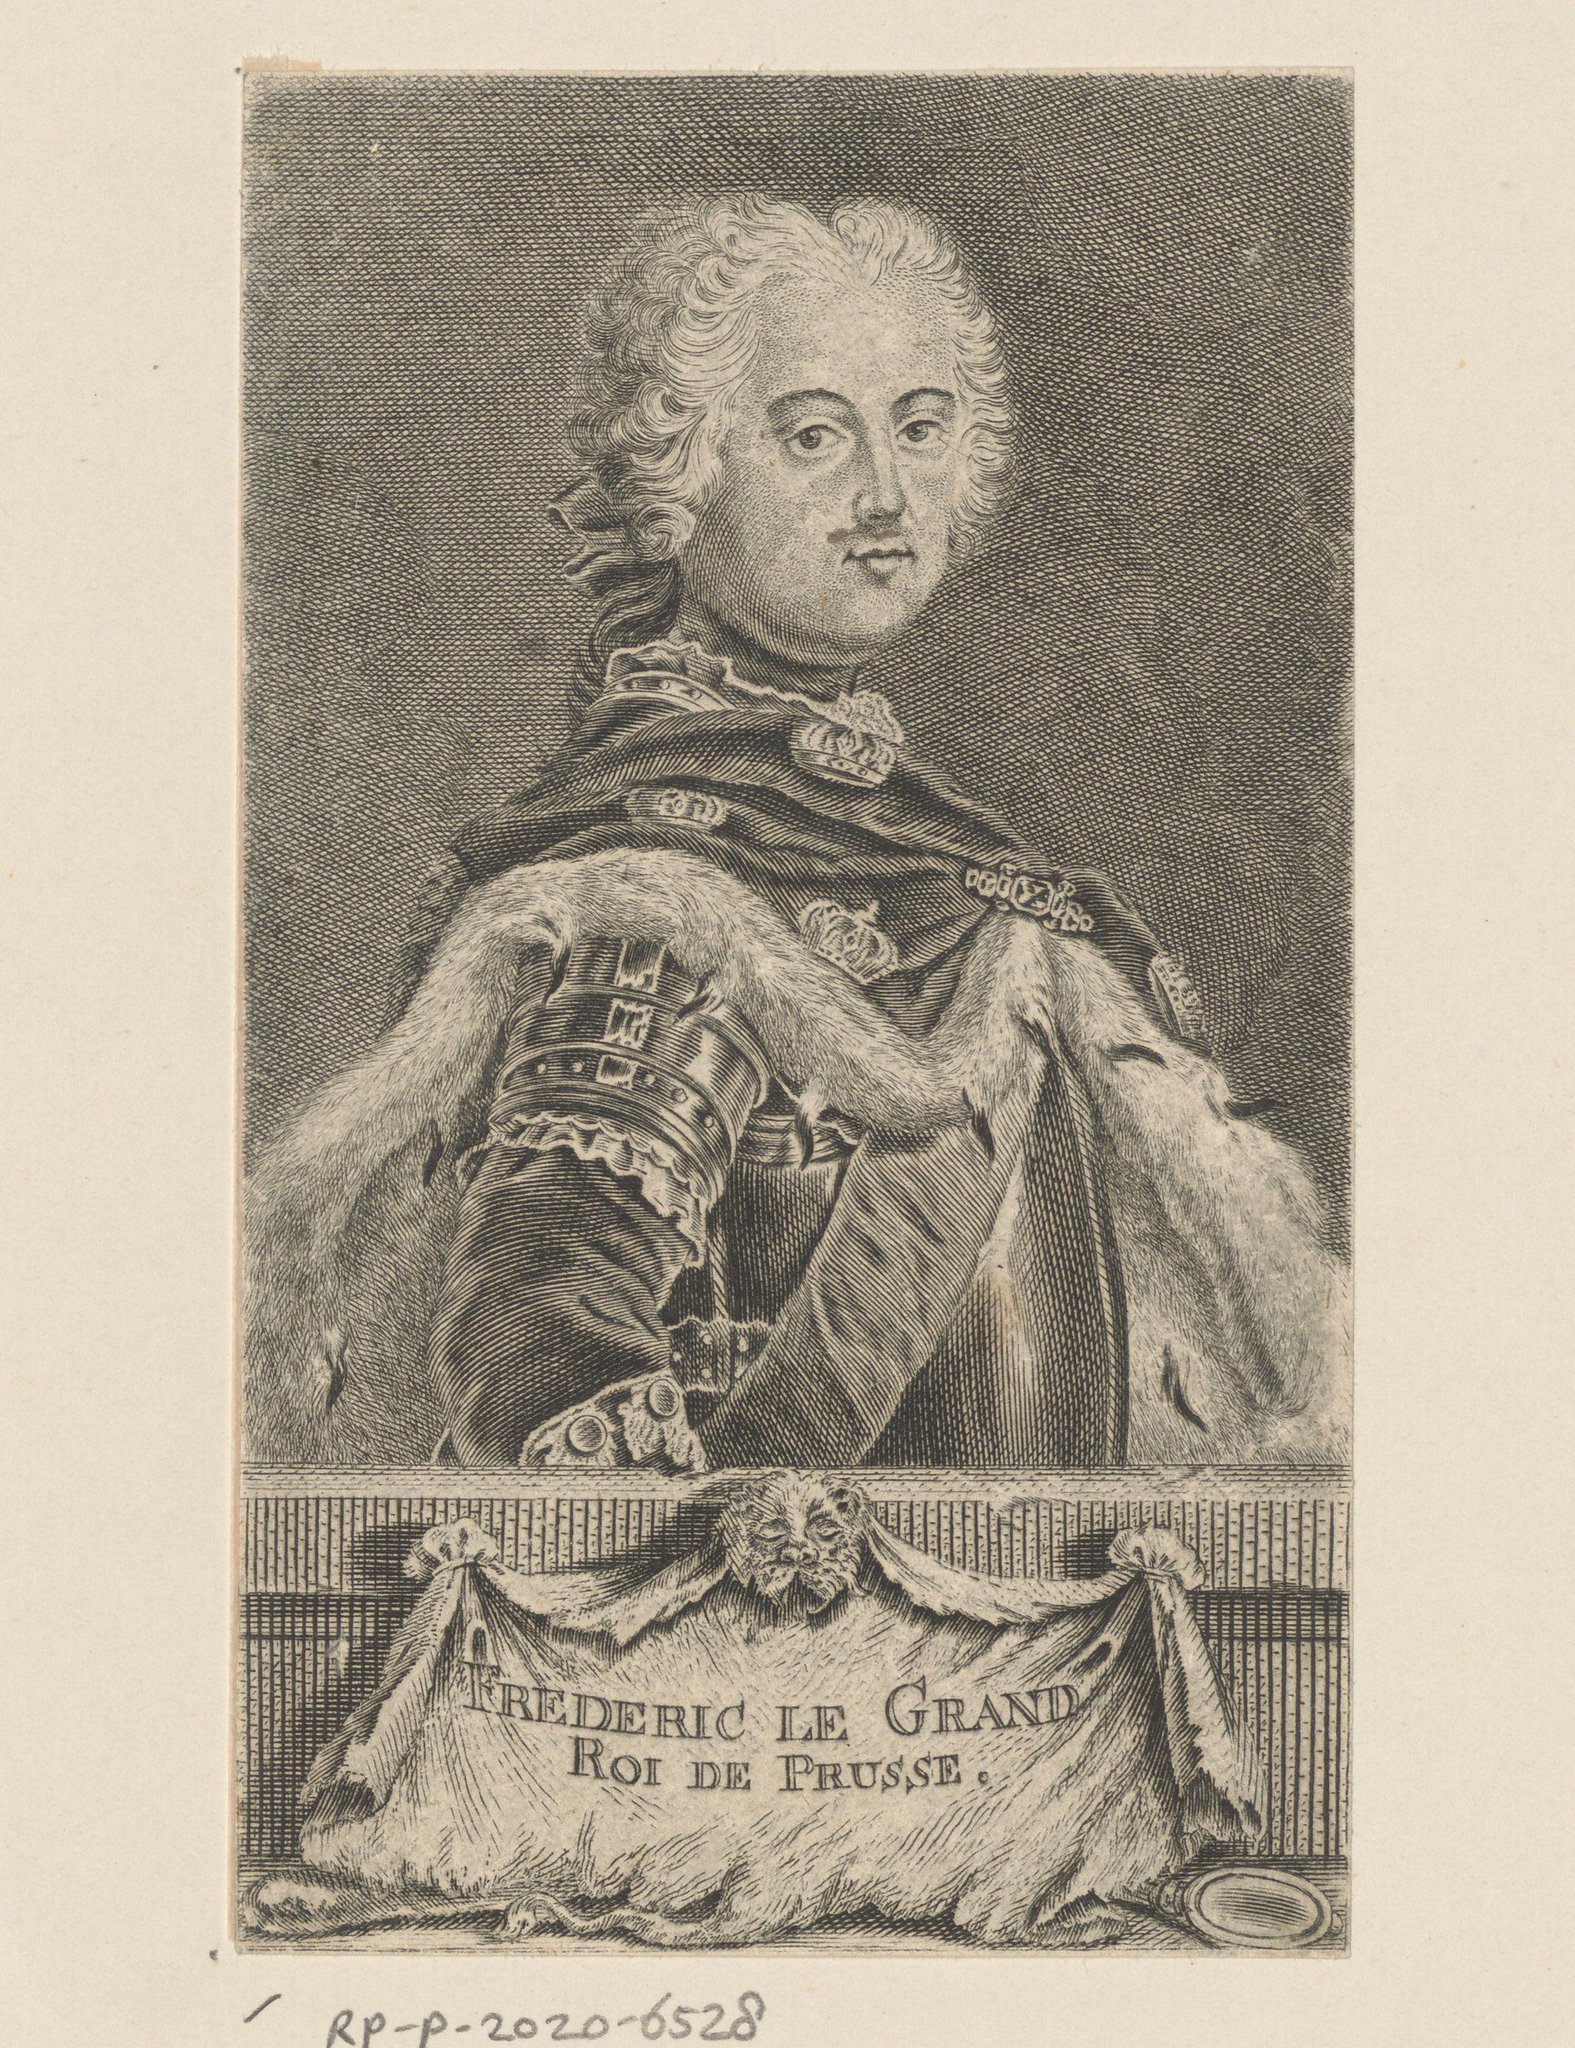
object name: print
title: Portret van Frederik de Grote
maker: Anonymous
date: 1757-1799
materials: paper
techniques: engraving, etching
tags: berlin, frederick ii (king of prussia), historical persons, king